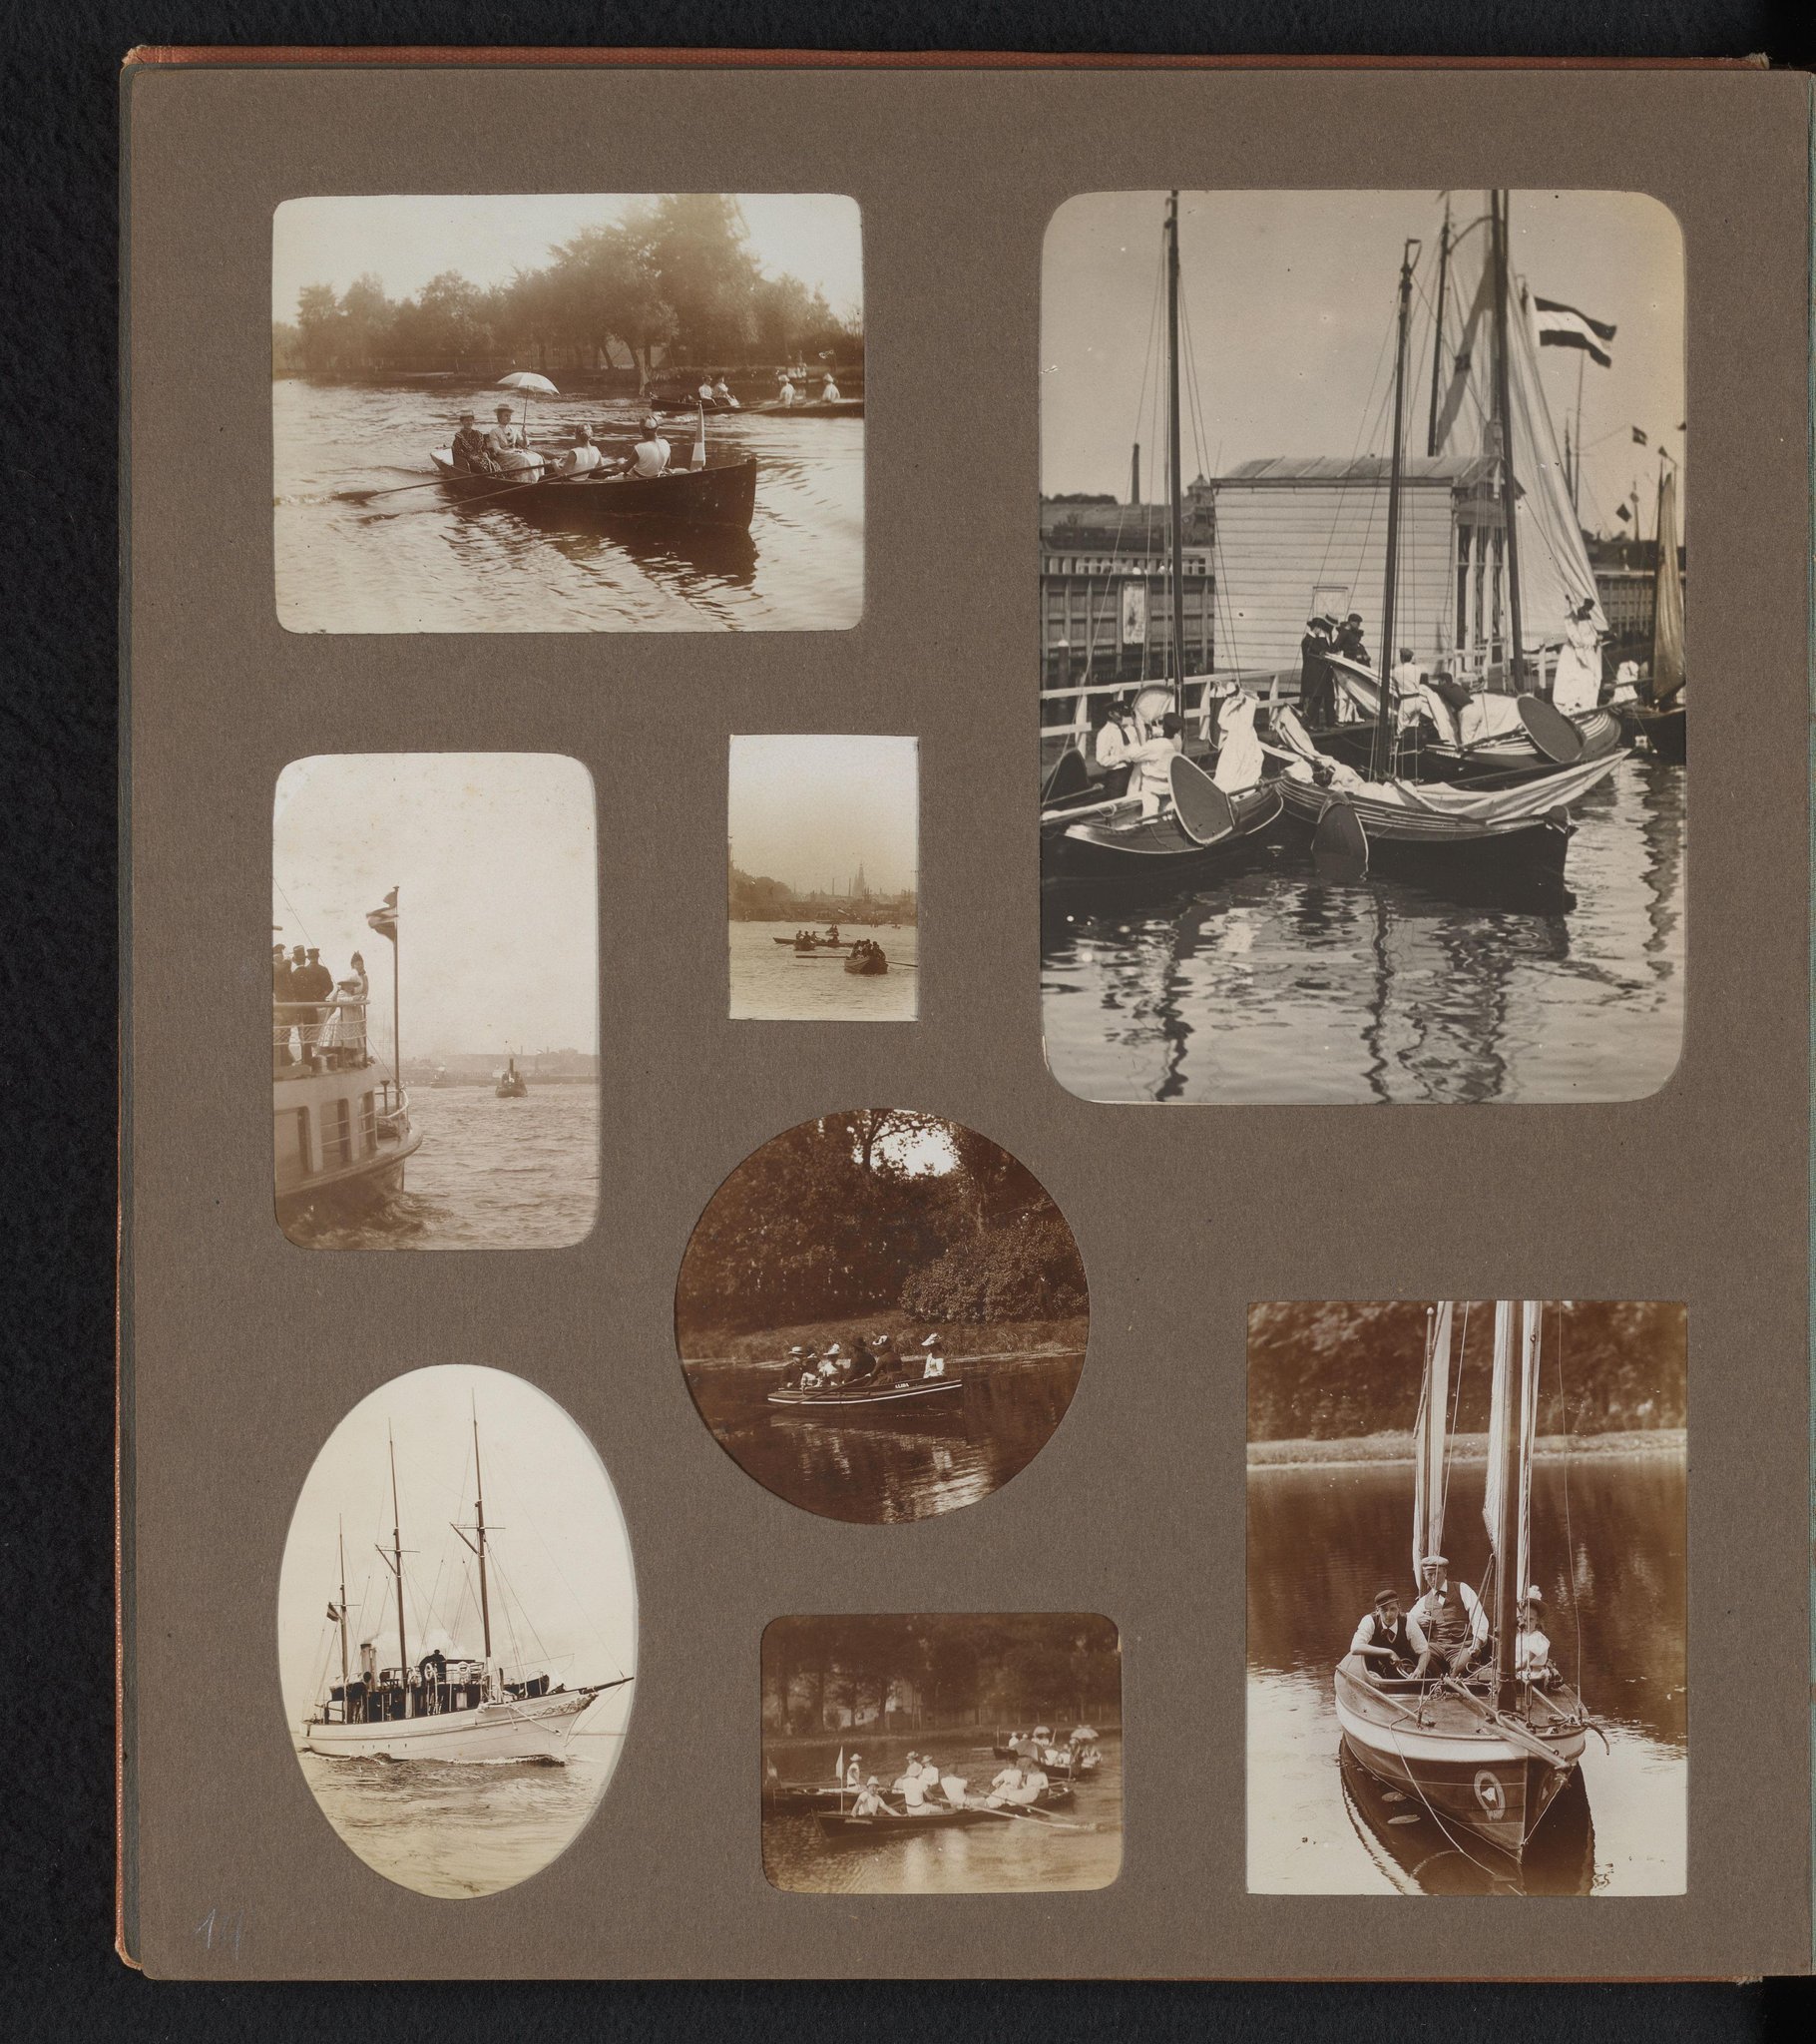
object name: photograph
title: Gezichten op diverse boten met mensen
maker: machiel gerrit george suyver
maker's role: fotograaf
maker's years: 1872-1933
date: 1890-1898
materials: paper, cardboard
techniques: gelatin silver print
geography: netherlands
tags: ships (in general), rowing-boat, canoe, etc.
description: Deze foto's maken deel uit van een album.